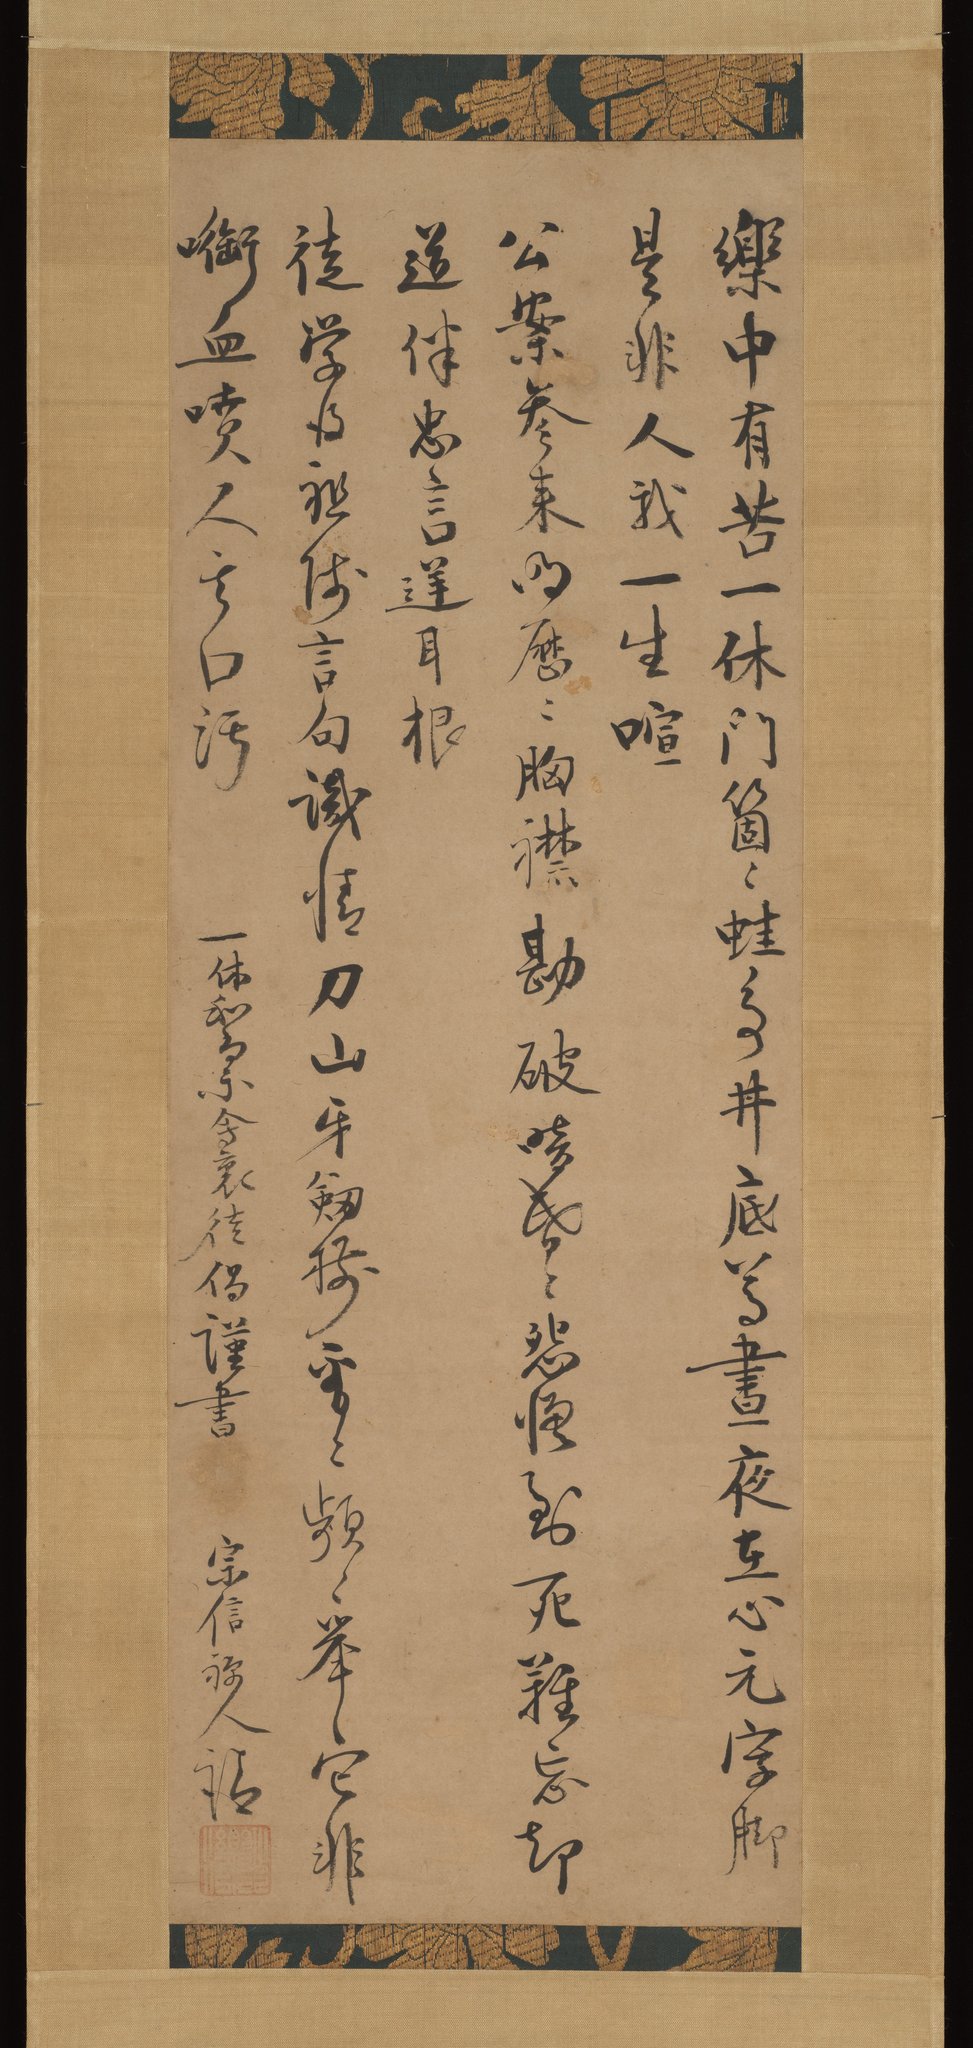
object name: hanging scroll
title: Three Poetic Verses of Teaching by Ikkyū Given to His Disciples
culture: japanese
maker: motsurin jōtō (bokusai)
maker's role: artist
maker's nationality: japanese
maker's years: -1492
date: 1467-1500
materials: ink, paper